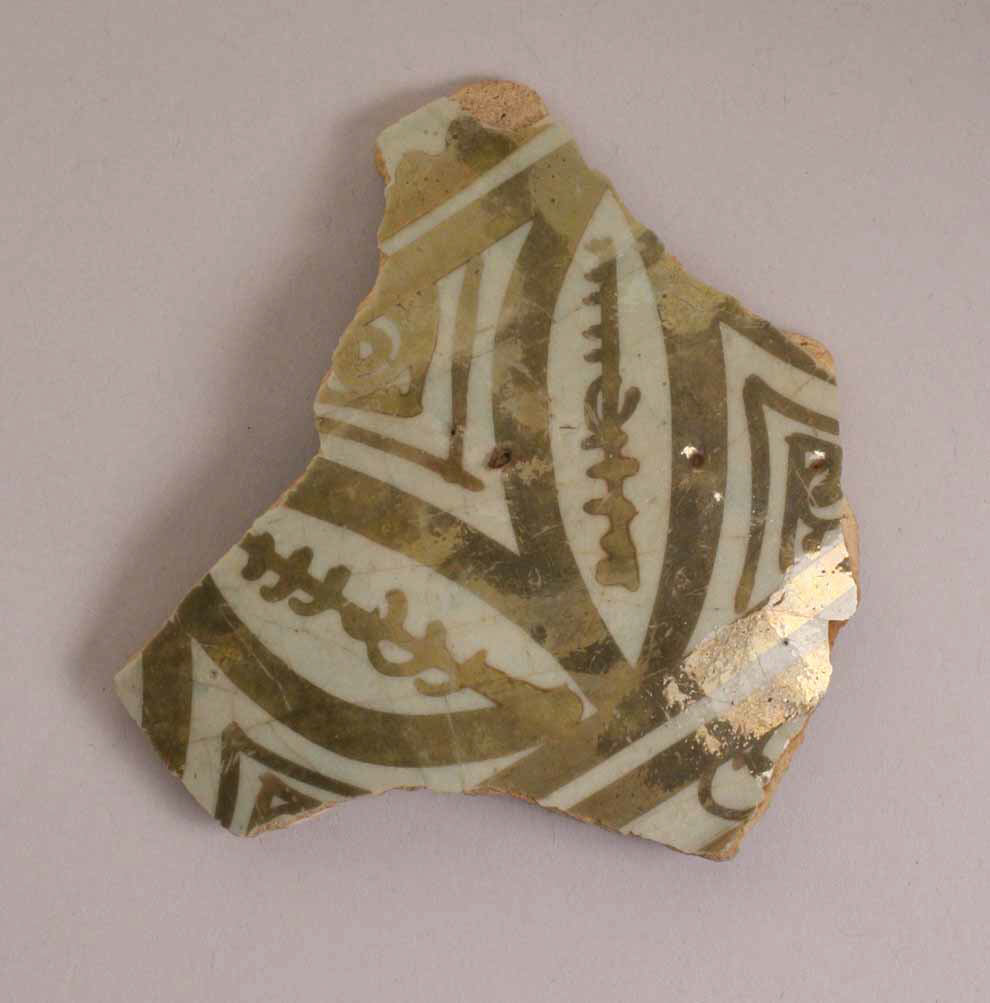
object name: fragment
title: Ceramic Fragment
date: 1001-1200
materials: tin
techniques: enamel, luster painting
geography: syria